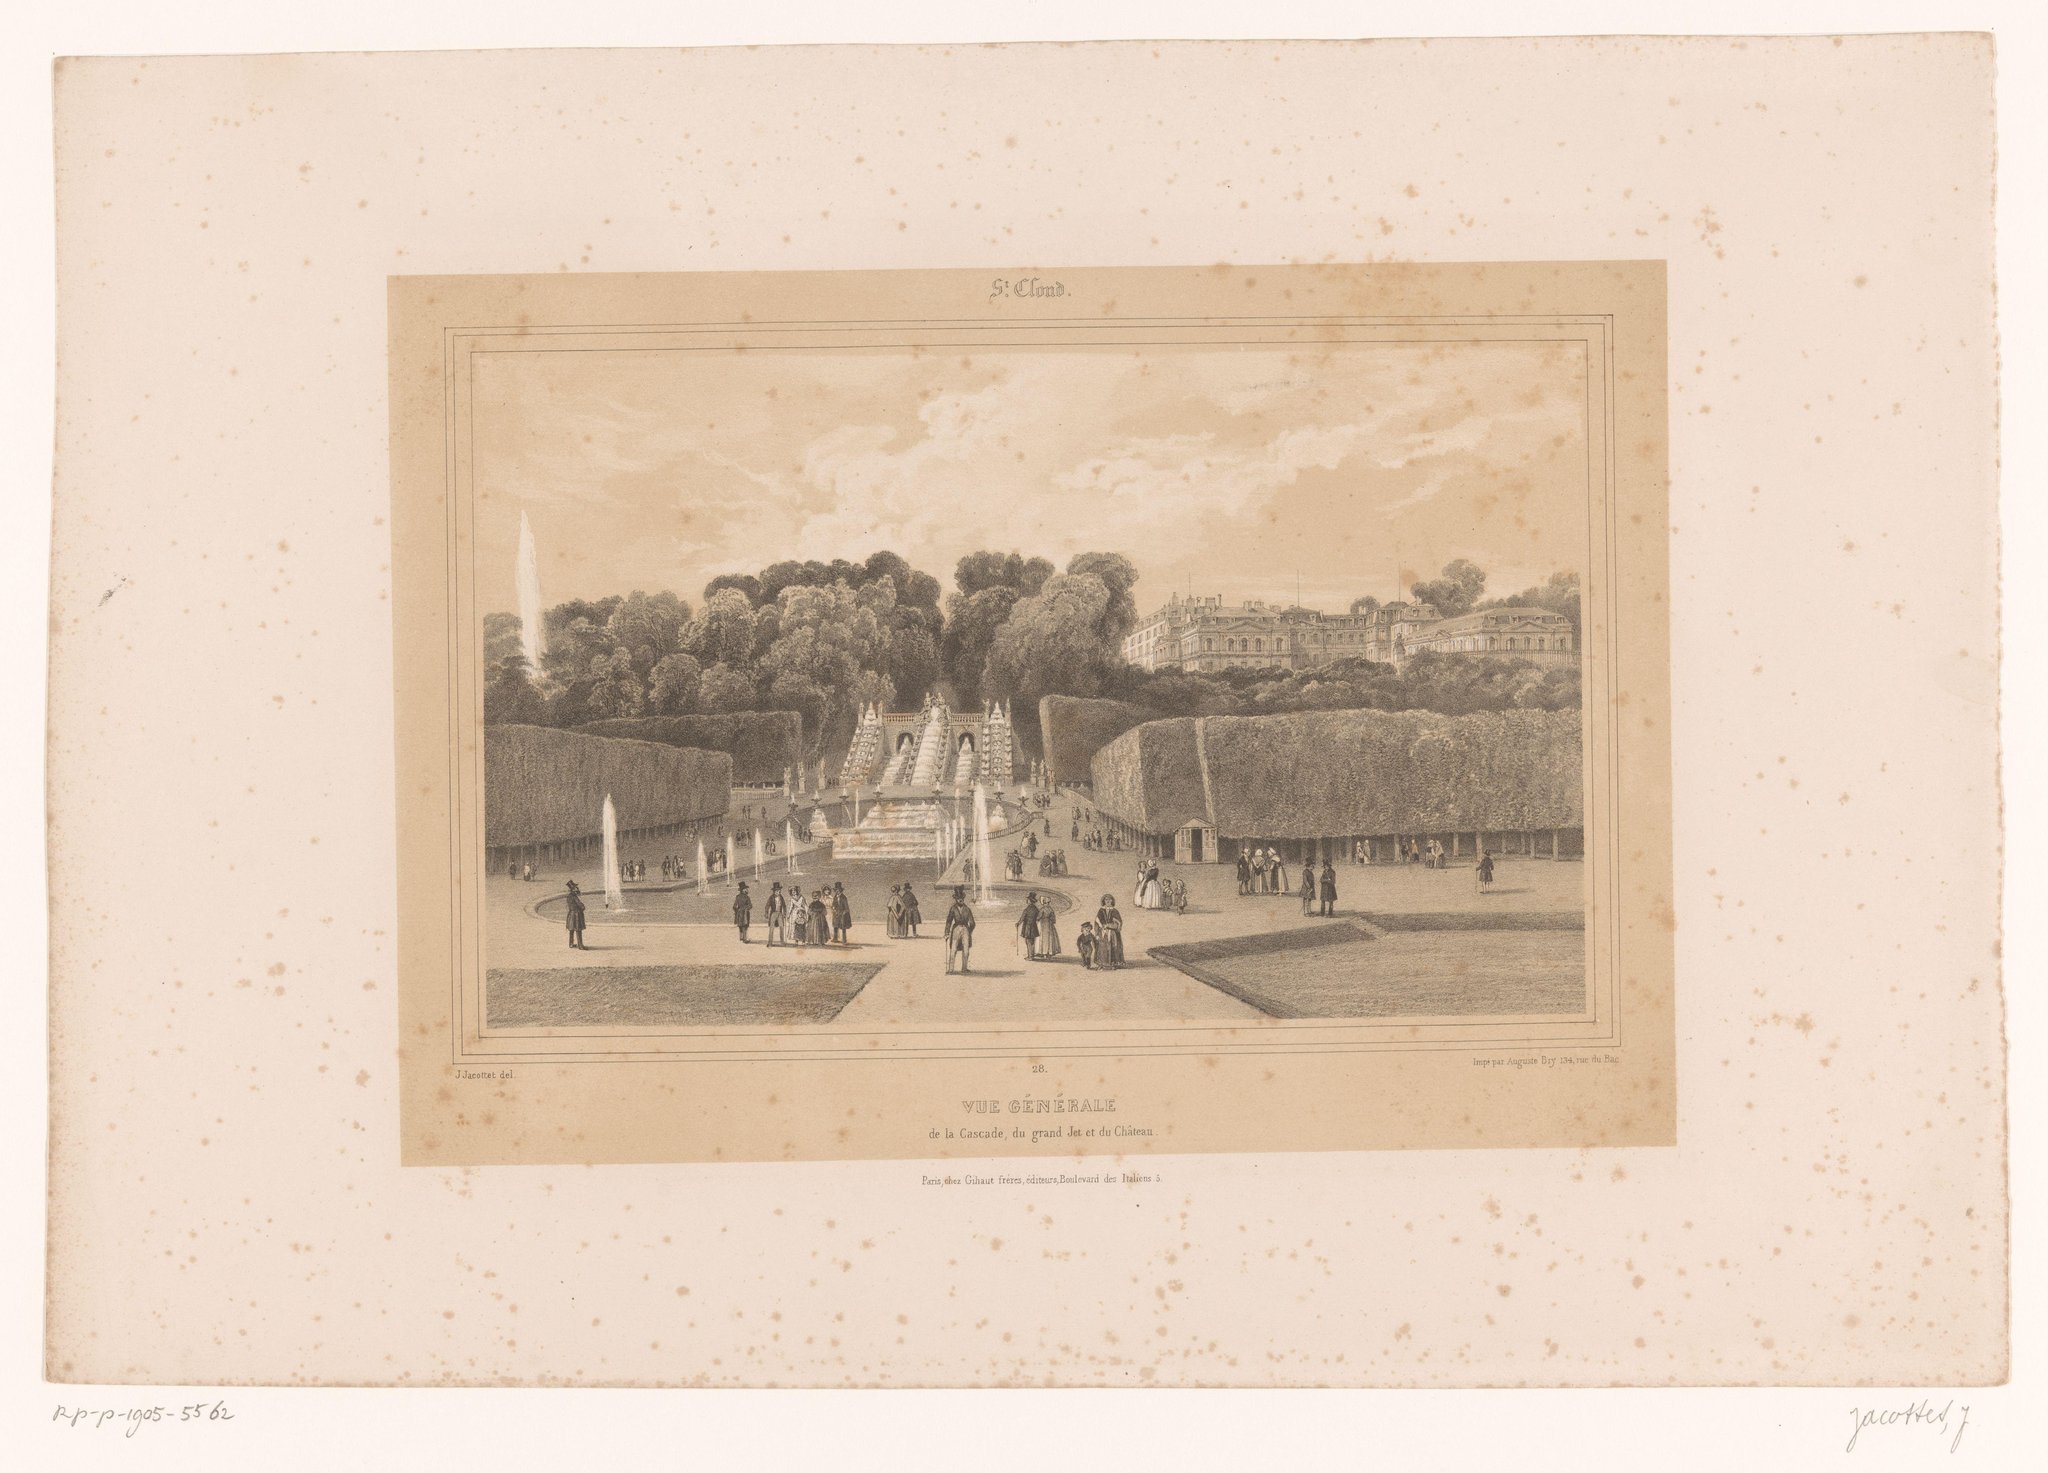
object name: print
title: Zicht op het kasteel van Saint-Cloud in het park van Saint-Cloud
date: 1838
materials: paper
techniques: tone lithography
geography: paris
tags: public gardens, park (+ city(-scape) with figures, staffage), palace, garden cascade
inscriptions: collector's mark: Lugt 2228a